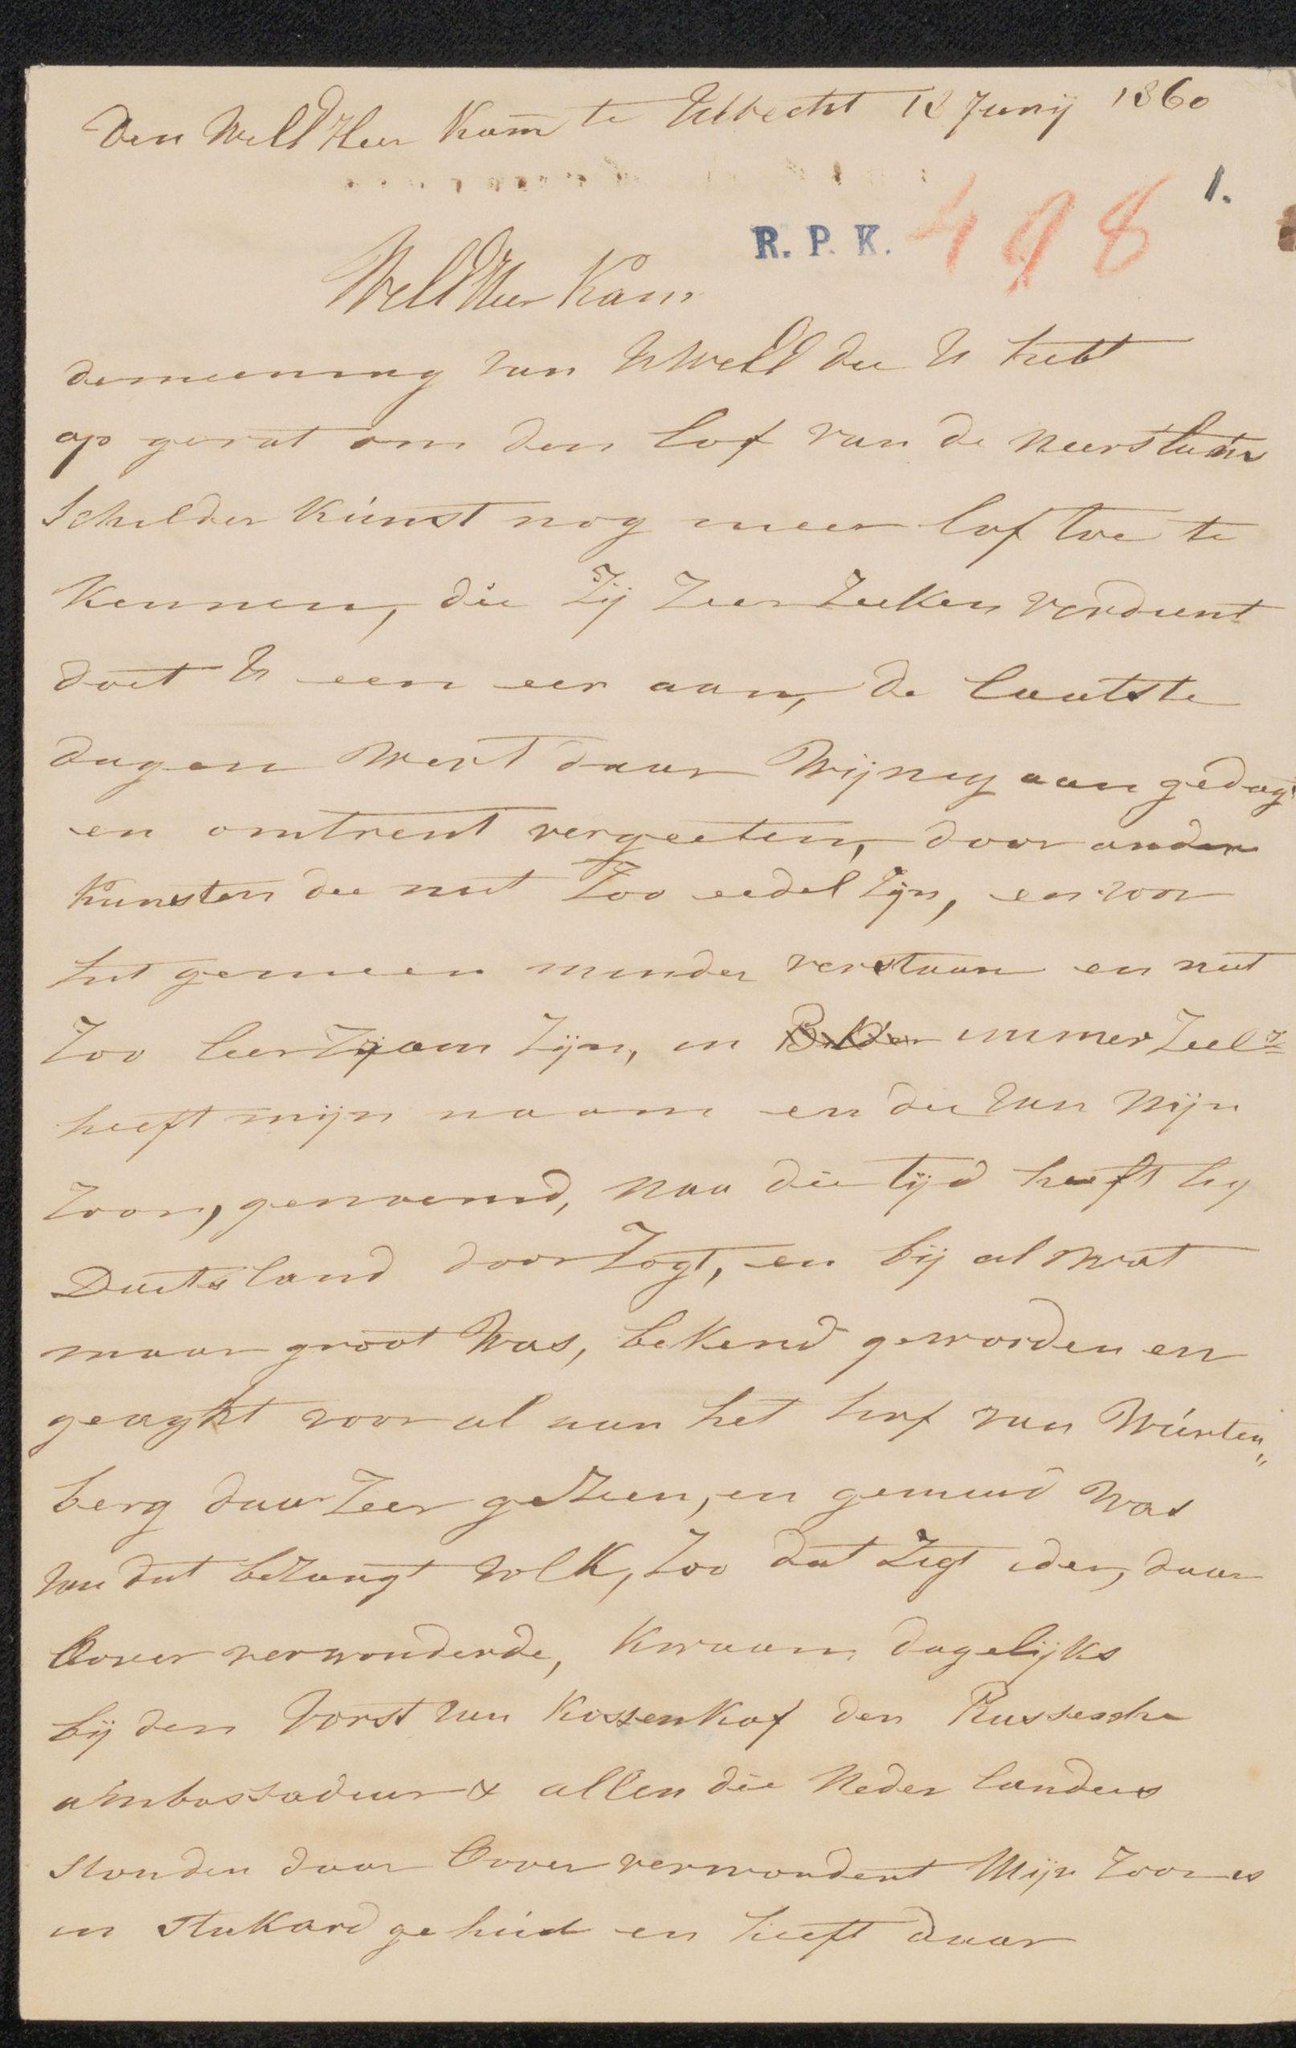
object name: letter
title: Brief aan Christiaan Kramm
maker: pieter franciscus peters (i)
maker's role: draughtsman, painter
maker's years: 1787-1867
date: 1860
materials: ink, paper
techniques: pen, writing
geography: nijmegen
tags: utrecht, print maker, christiaan kramm, family life, art collecting